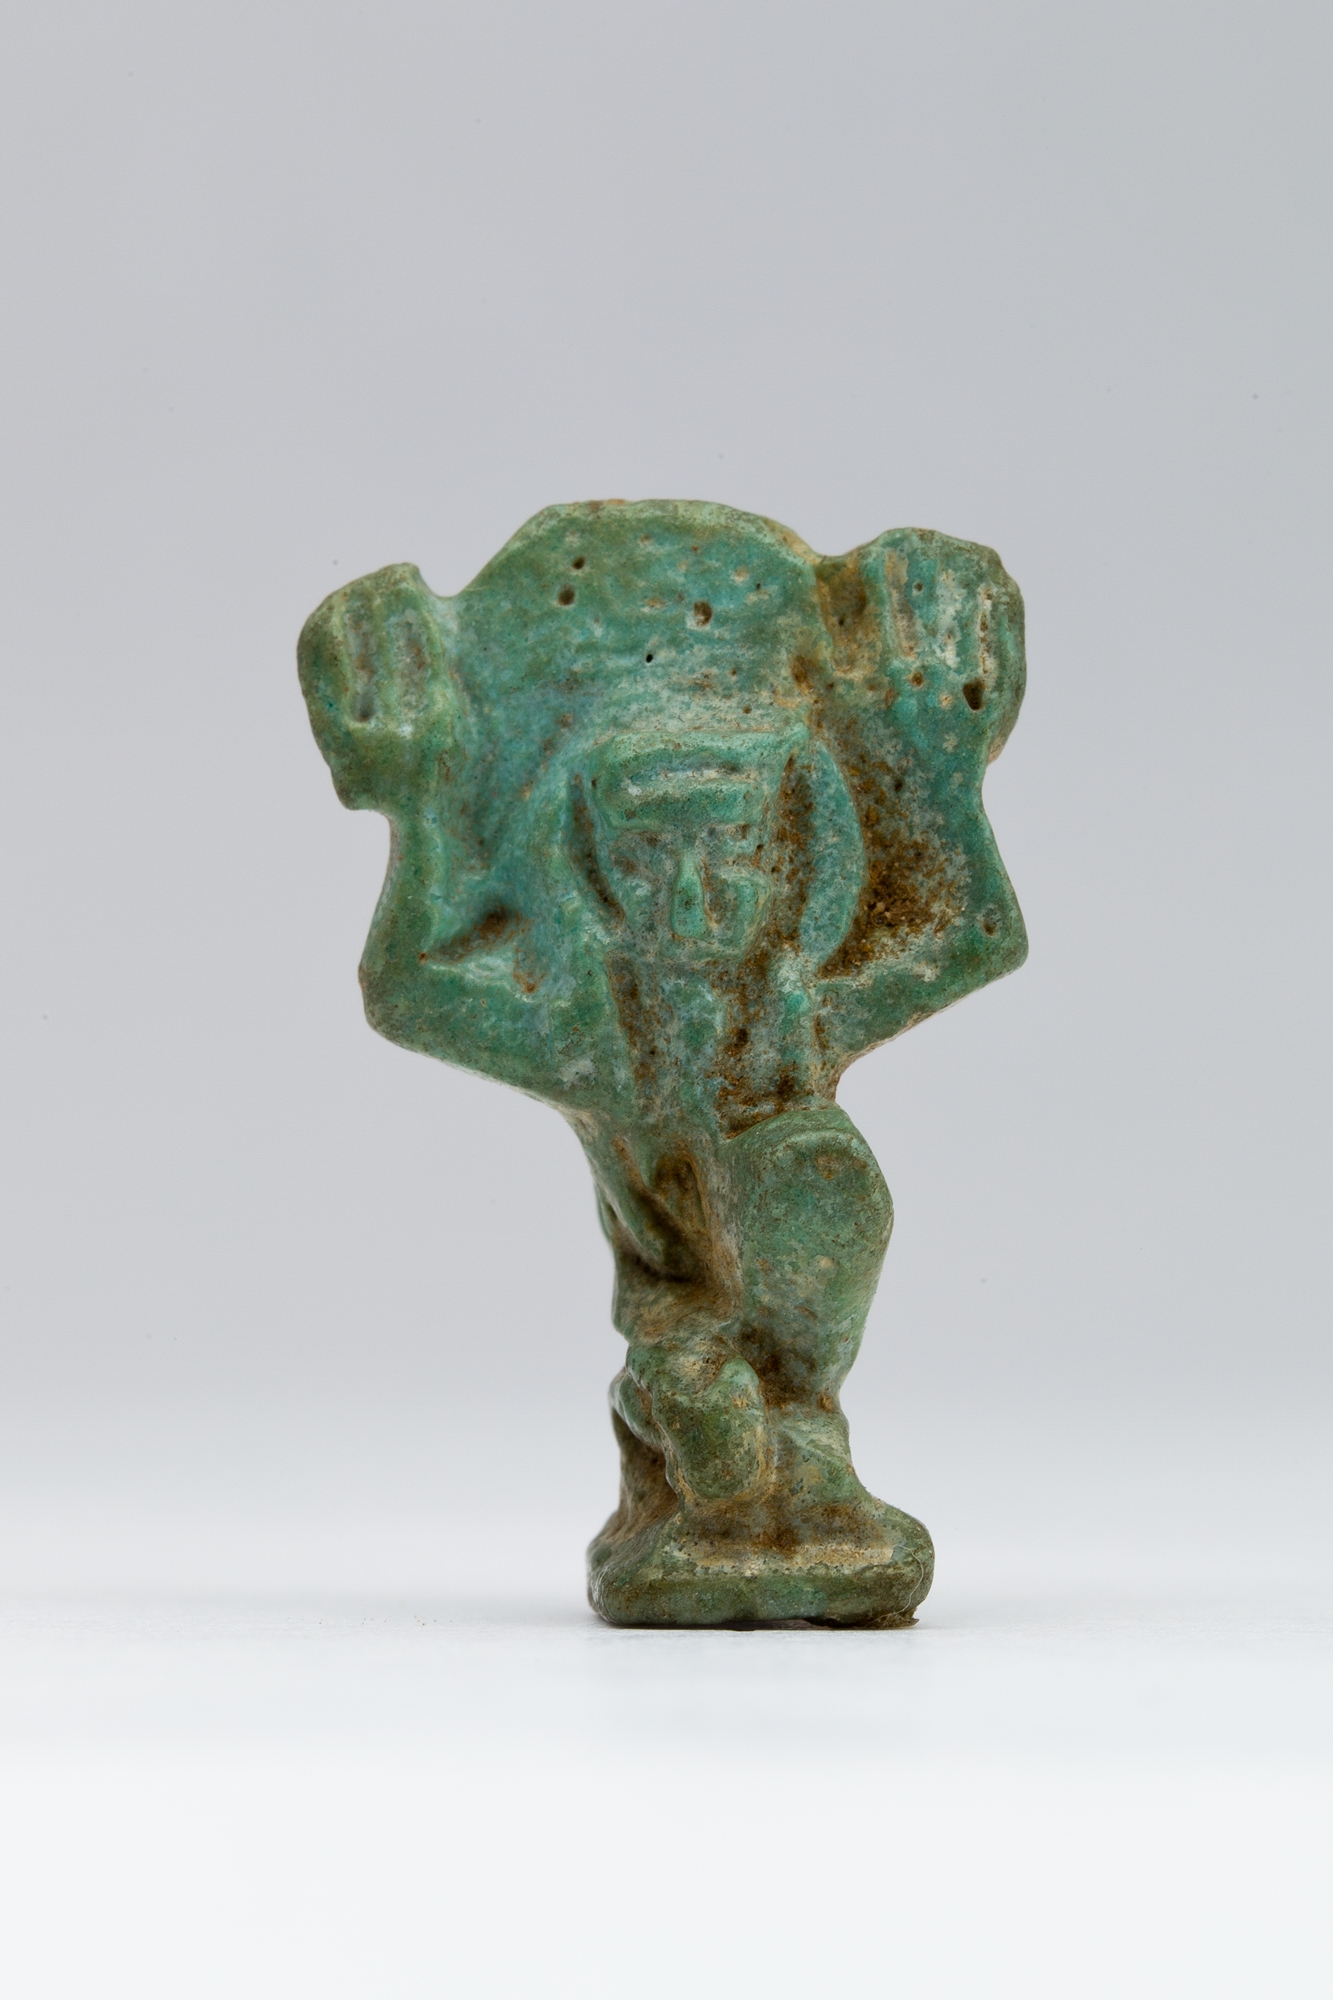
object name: amulet, shu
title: Shu amulet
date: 664-332 BCE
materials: faience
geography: egypt